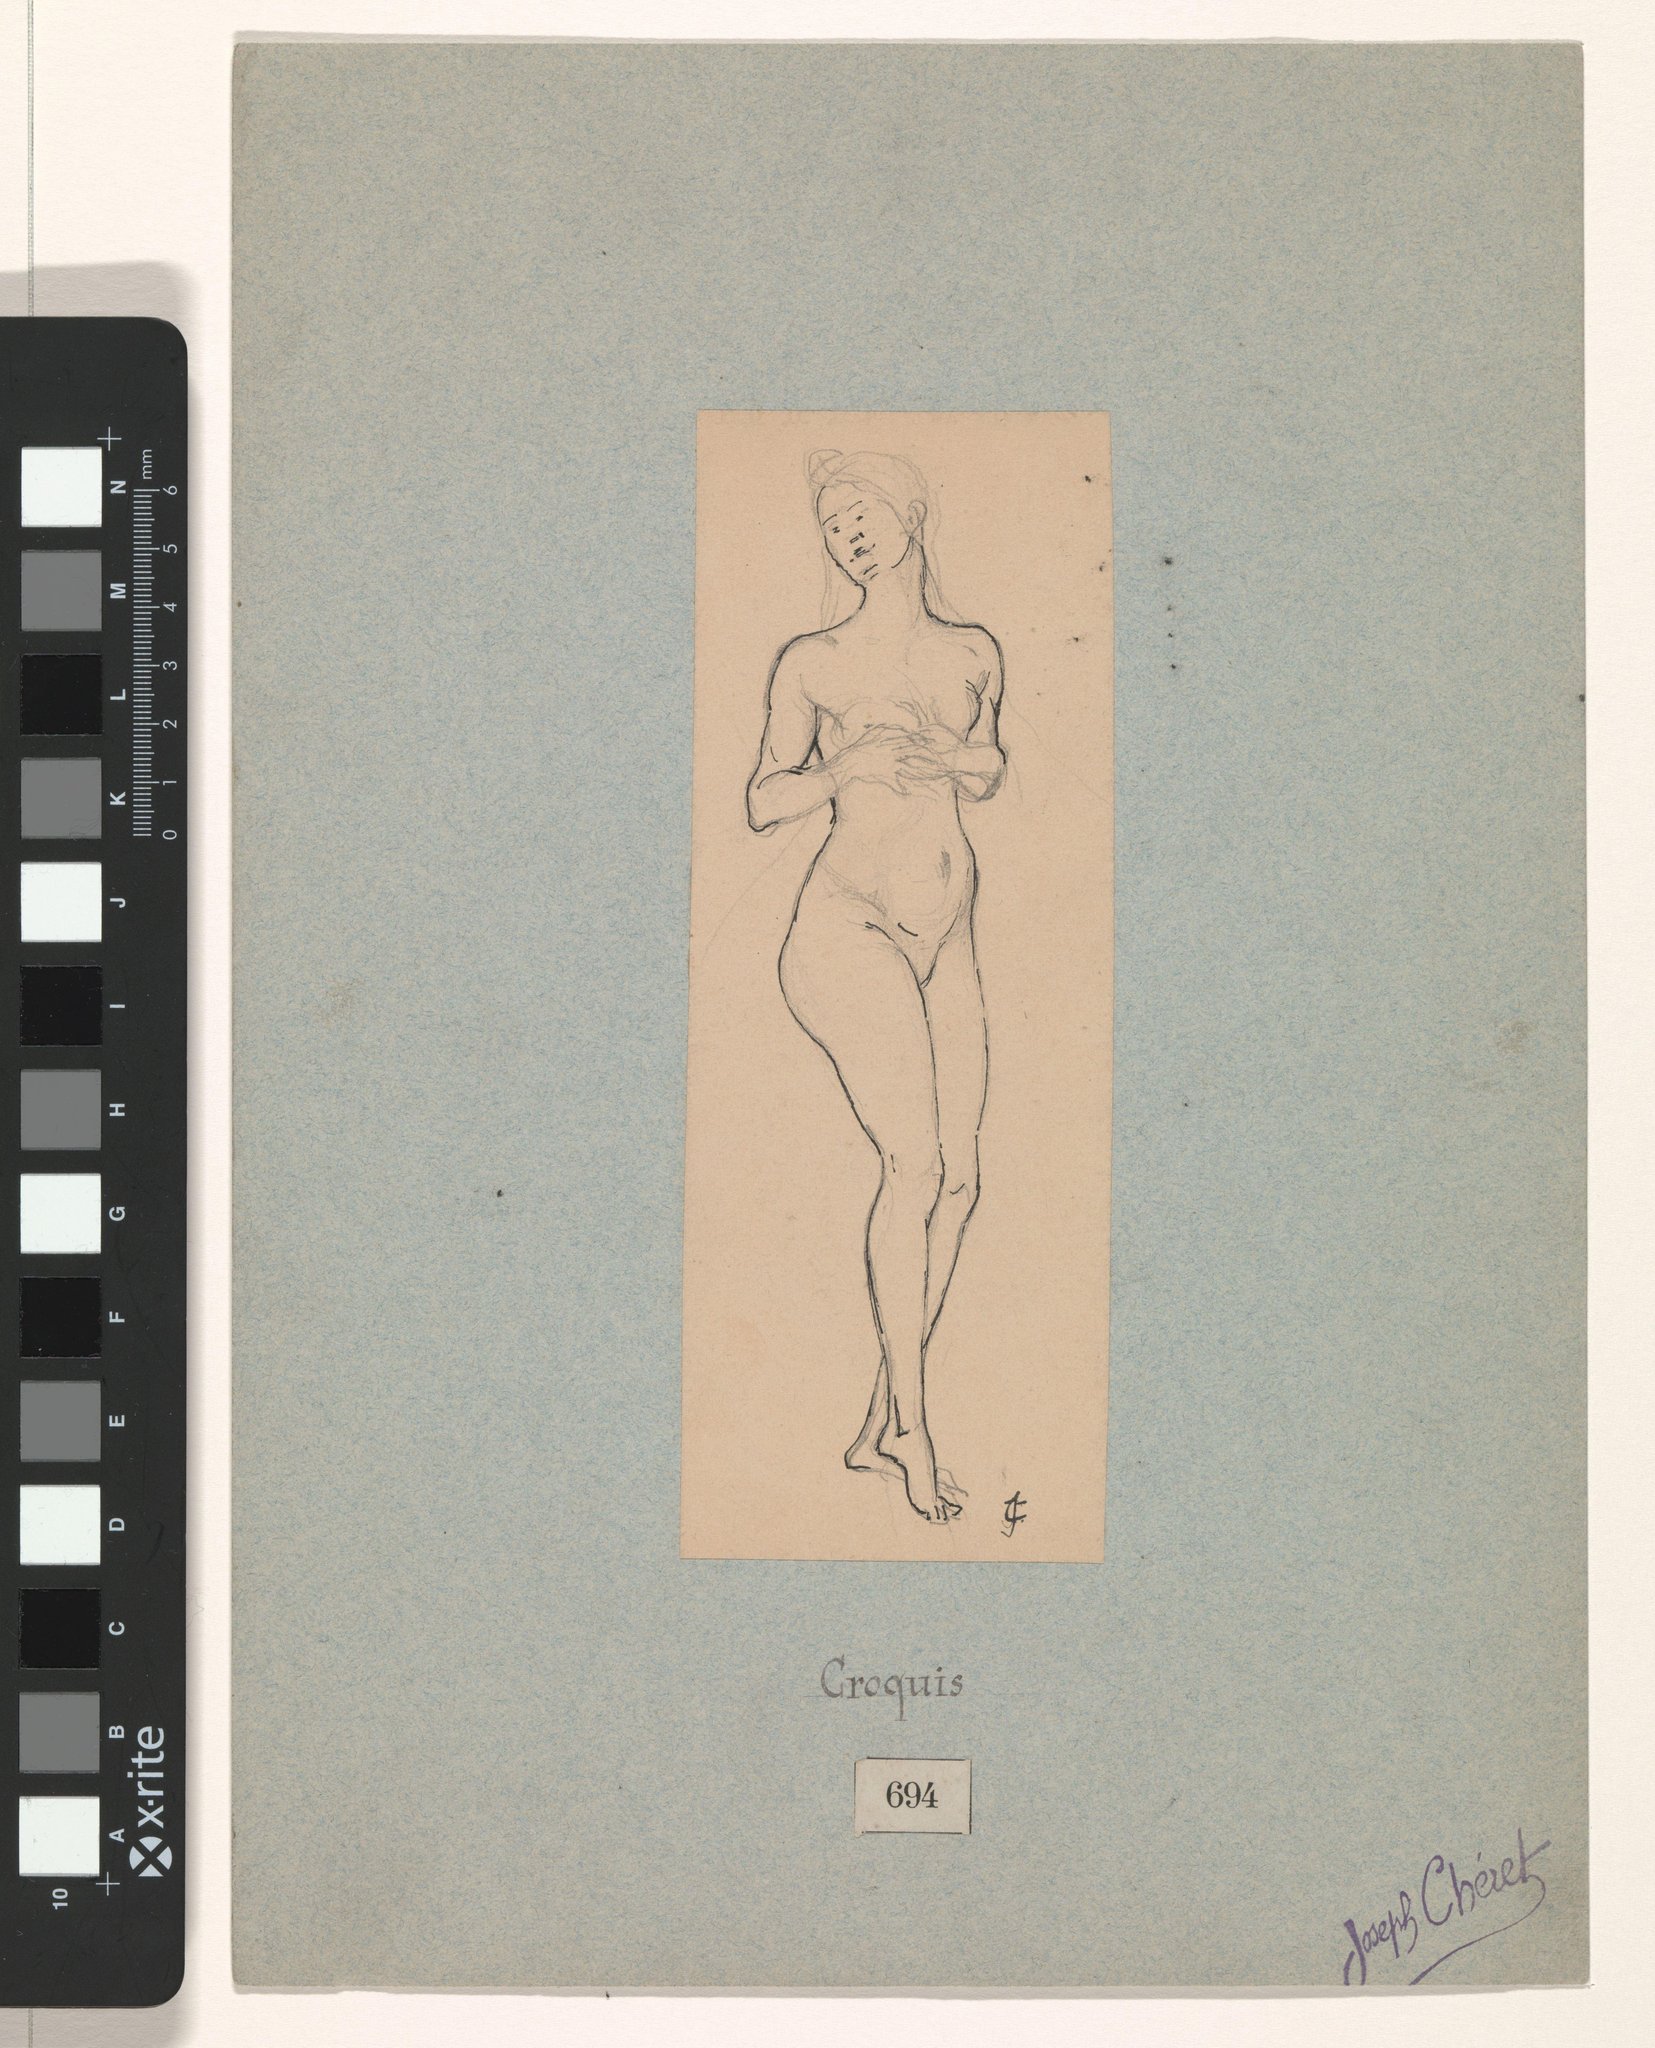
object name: design drawing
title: Naakte vrouw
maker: gustave joseph chéret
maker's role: sculptor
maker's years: 1838-1894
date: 1870-1894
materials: cardboard, graphite, ink, paper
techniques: pen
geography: paris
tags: standing figure - aa - female human figure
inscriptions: monogram, workshop stamp: ‘Joseph Chéret’, inscription: ‘Croquis’, label: ‘694’